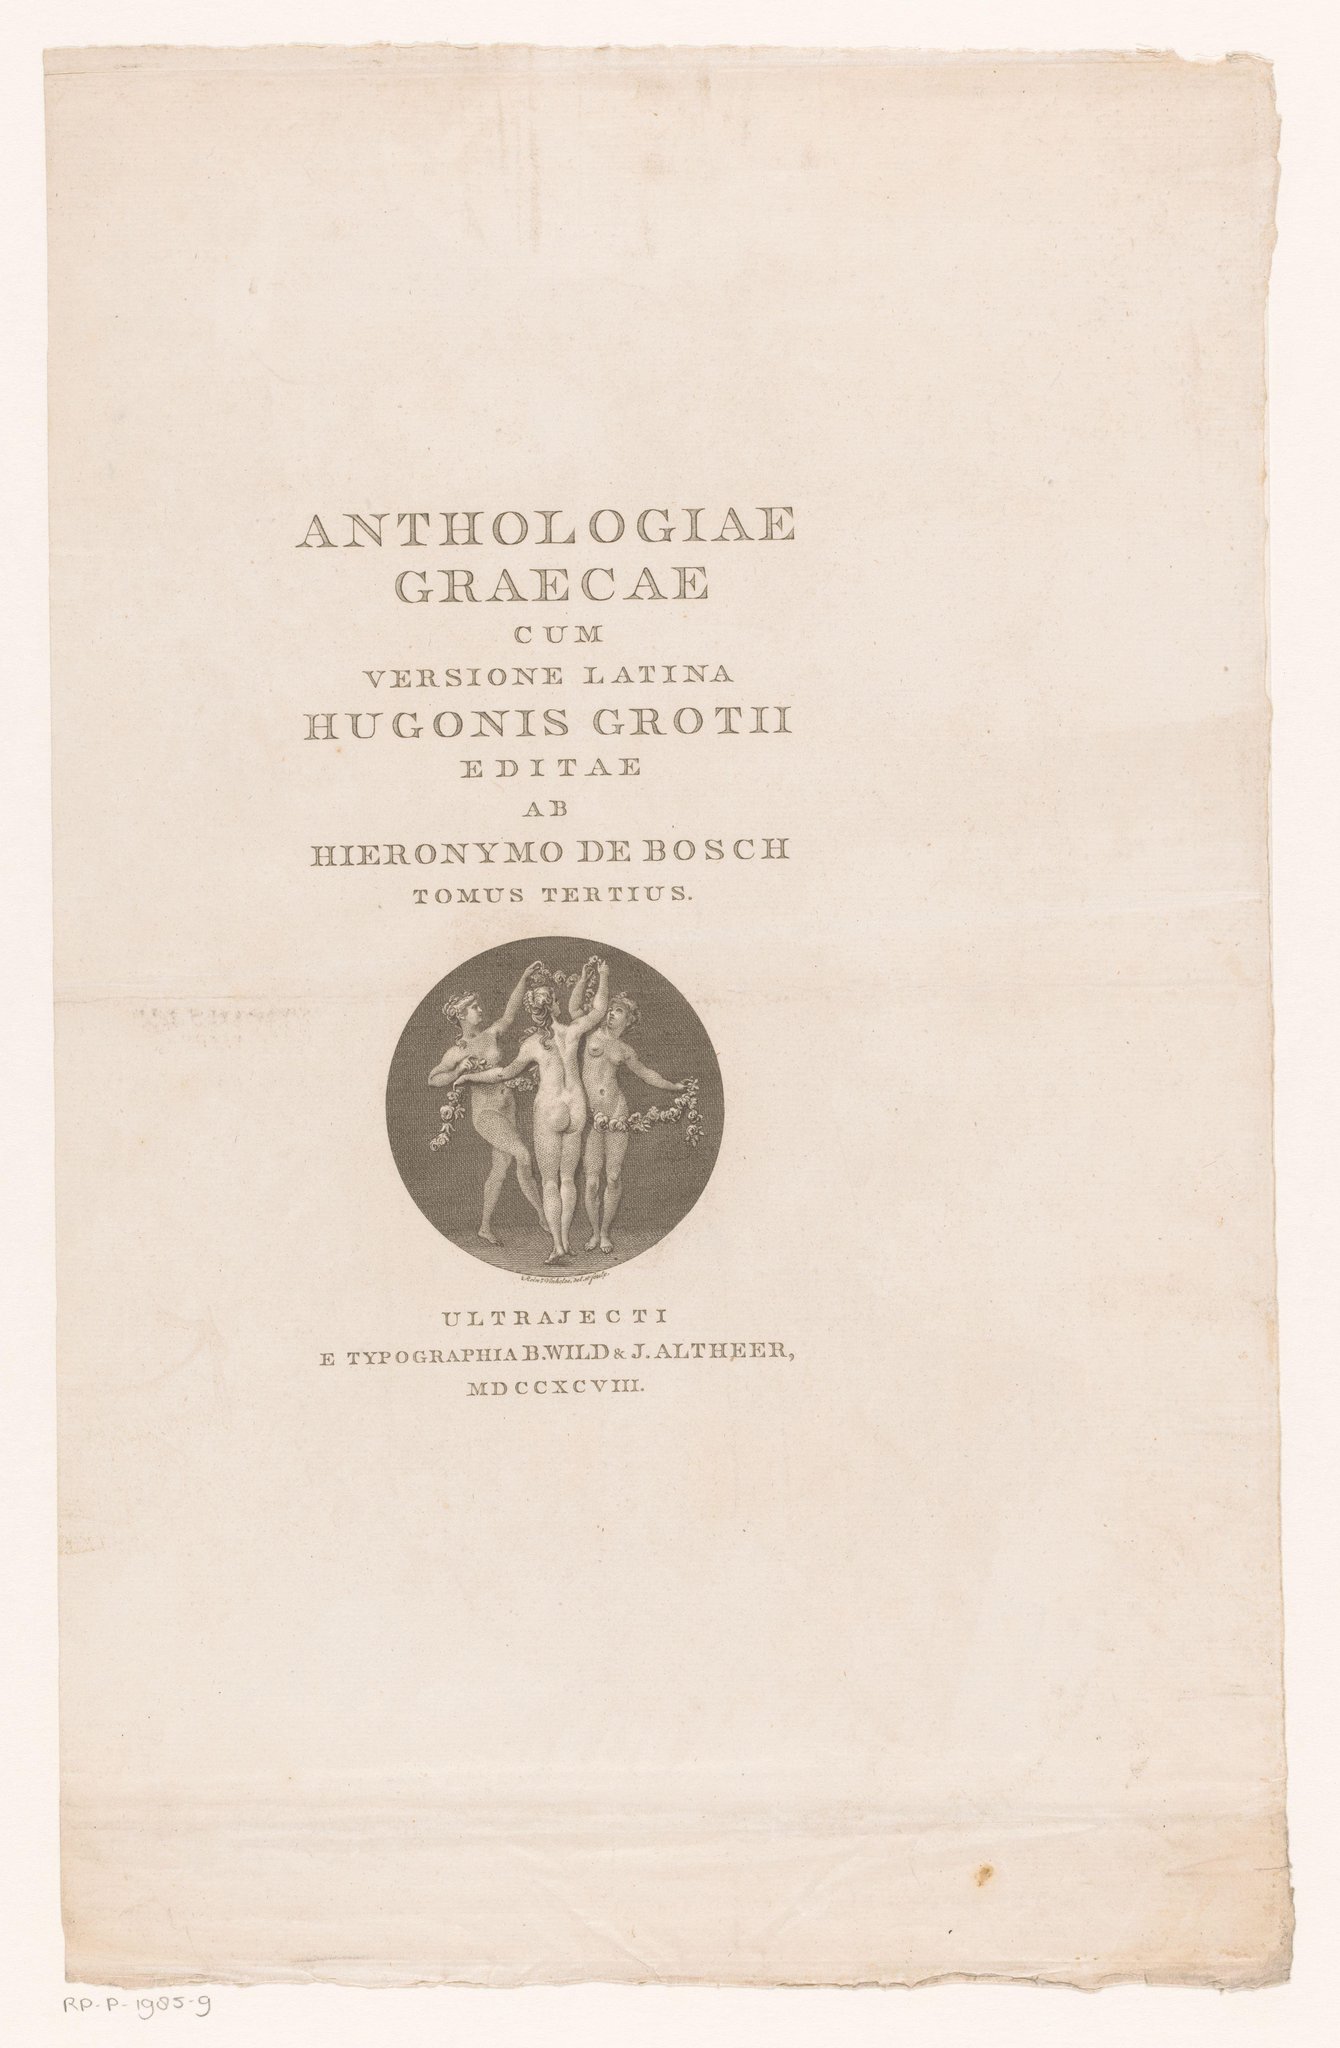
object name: titelblad, titelpagina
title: Medaillon met drie Gratiën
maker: reinier vinkeles (i)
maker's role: draughtsman, print maker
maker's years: 1741-1816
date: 1798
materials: paper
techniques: engraving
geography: utrecht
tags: ornament ~ medallion, graces (charites), generally three in number; 'gratie' (ripa)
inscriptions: collector's mark: Lugt 2228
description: Titelpagina voor: S.n. Hieronymi de Bosch descriptio edendae anthologiae Graecae, ab Hugone Grotio Latinis versibus redditae. Utrecht: Wild & J. Altheer, B., 1798.